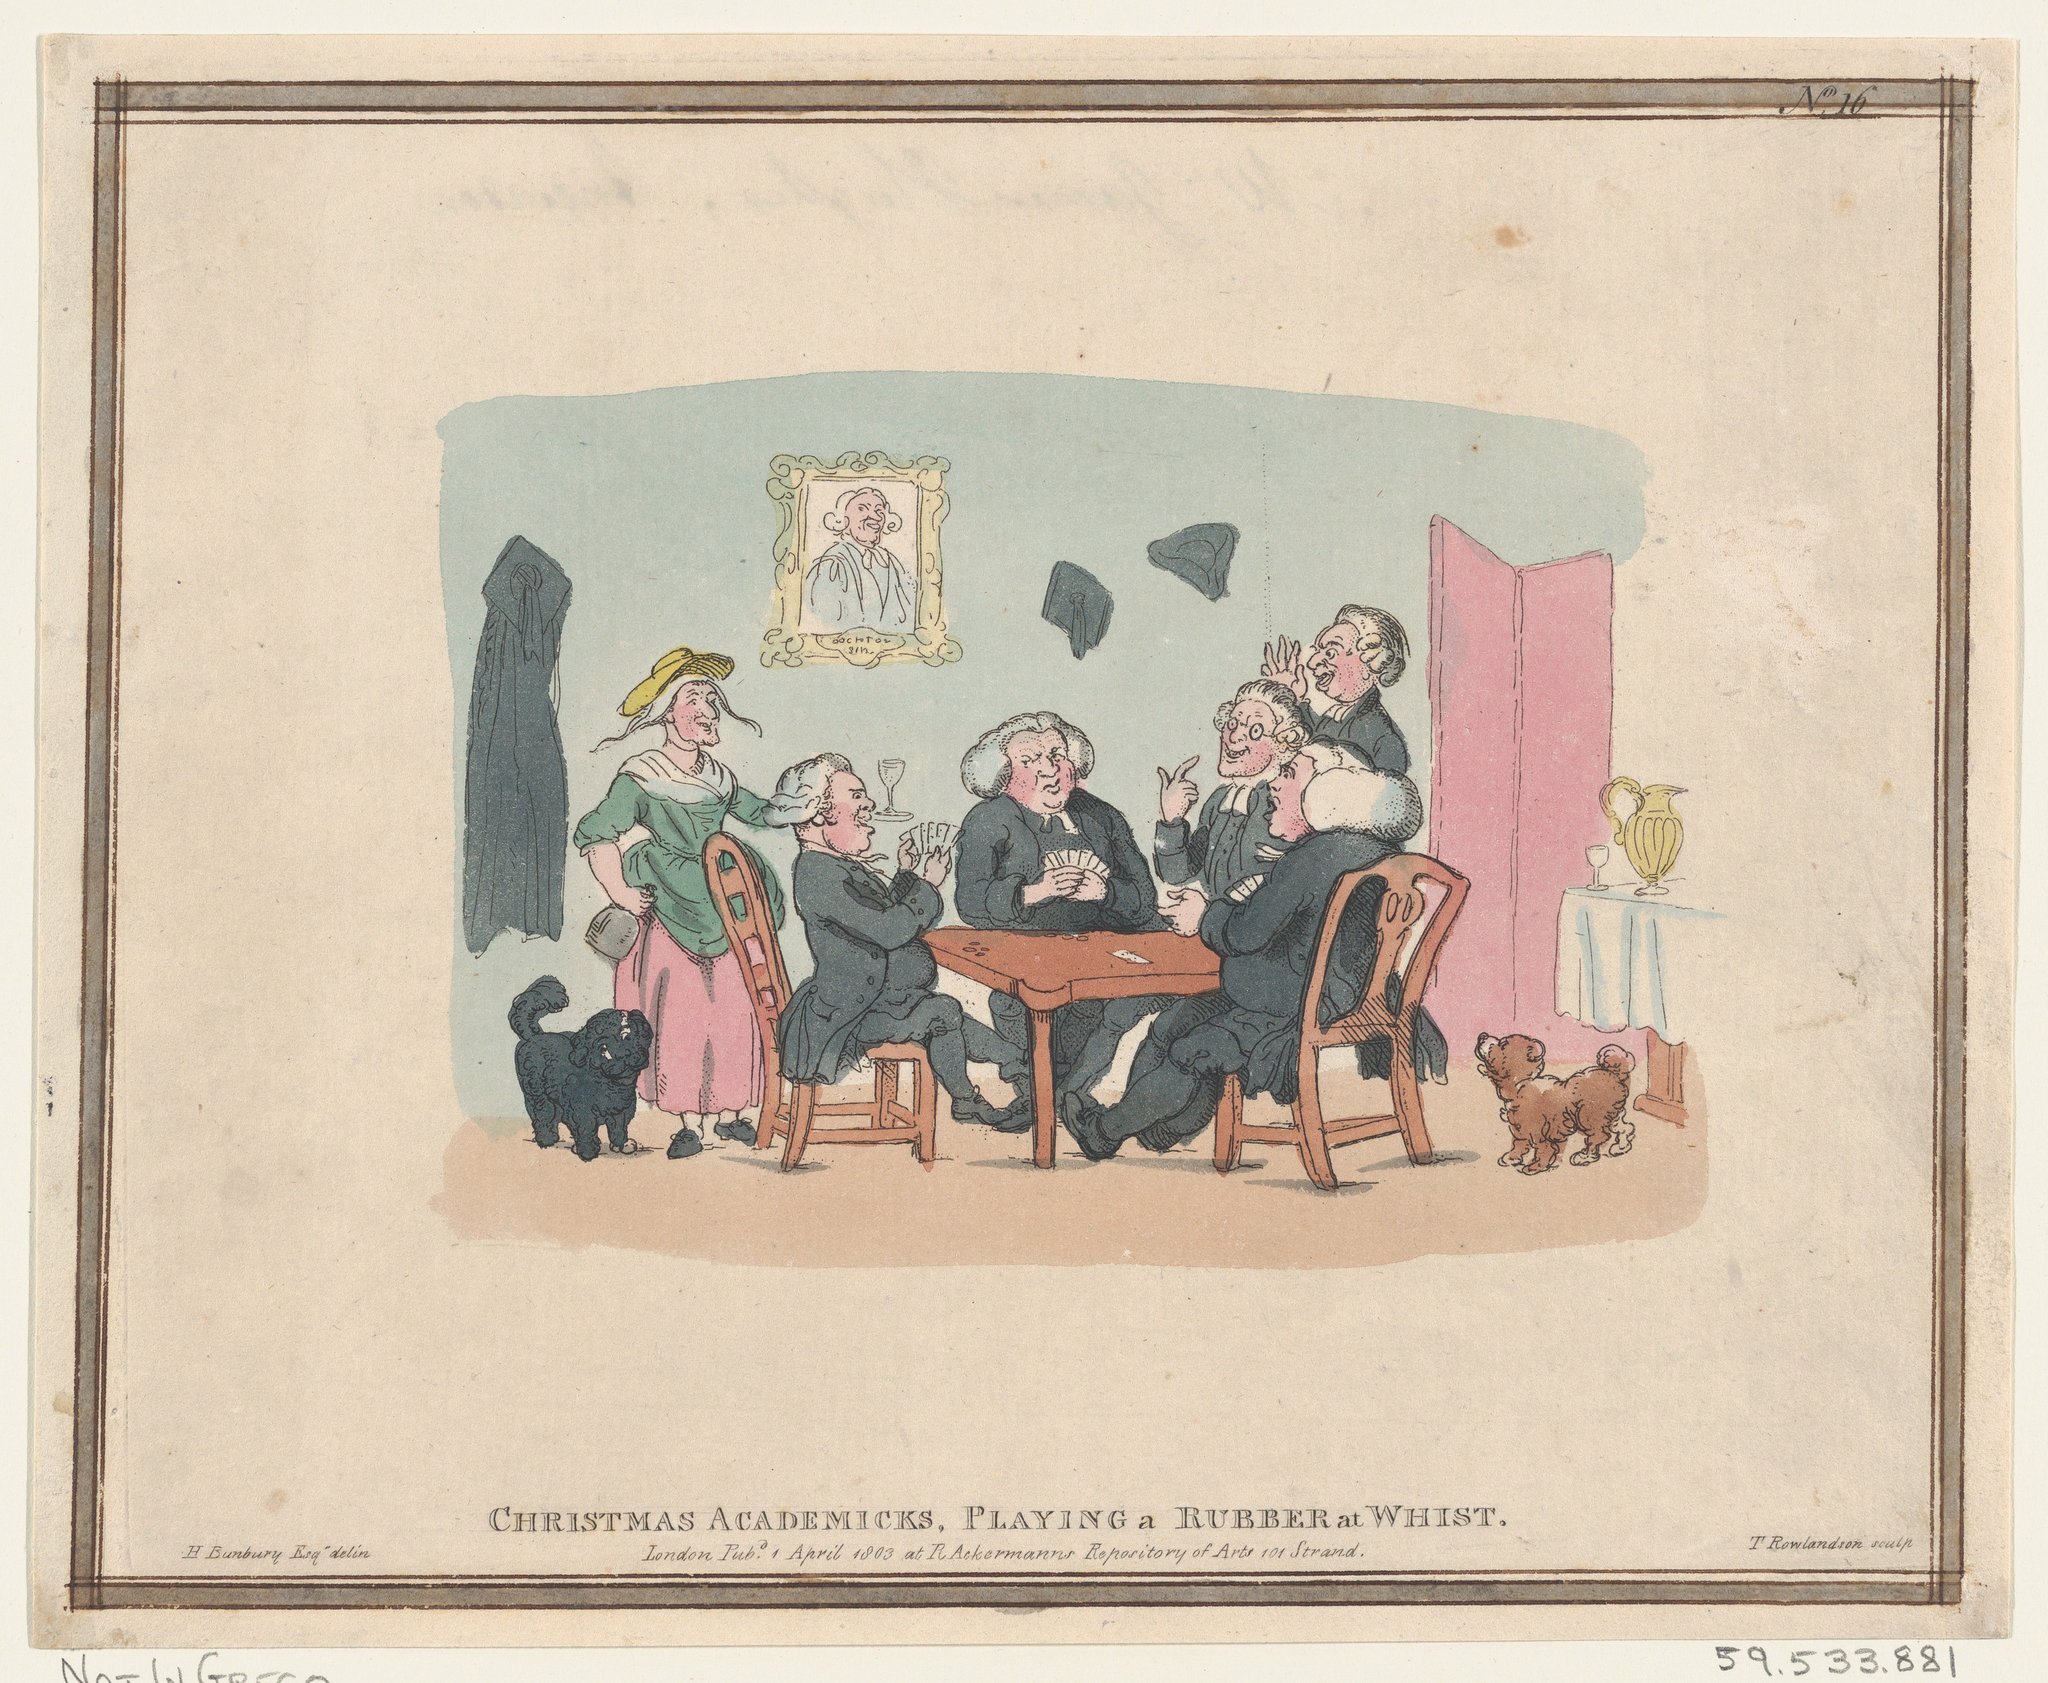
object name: print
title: Christmas Academics Playing a Rubber at Whist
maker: thomas rowlandson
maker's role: artist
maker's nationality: british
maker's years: 1757-1827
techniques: etching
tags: satire,men,women,playing cards,dogs,games